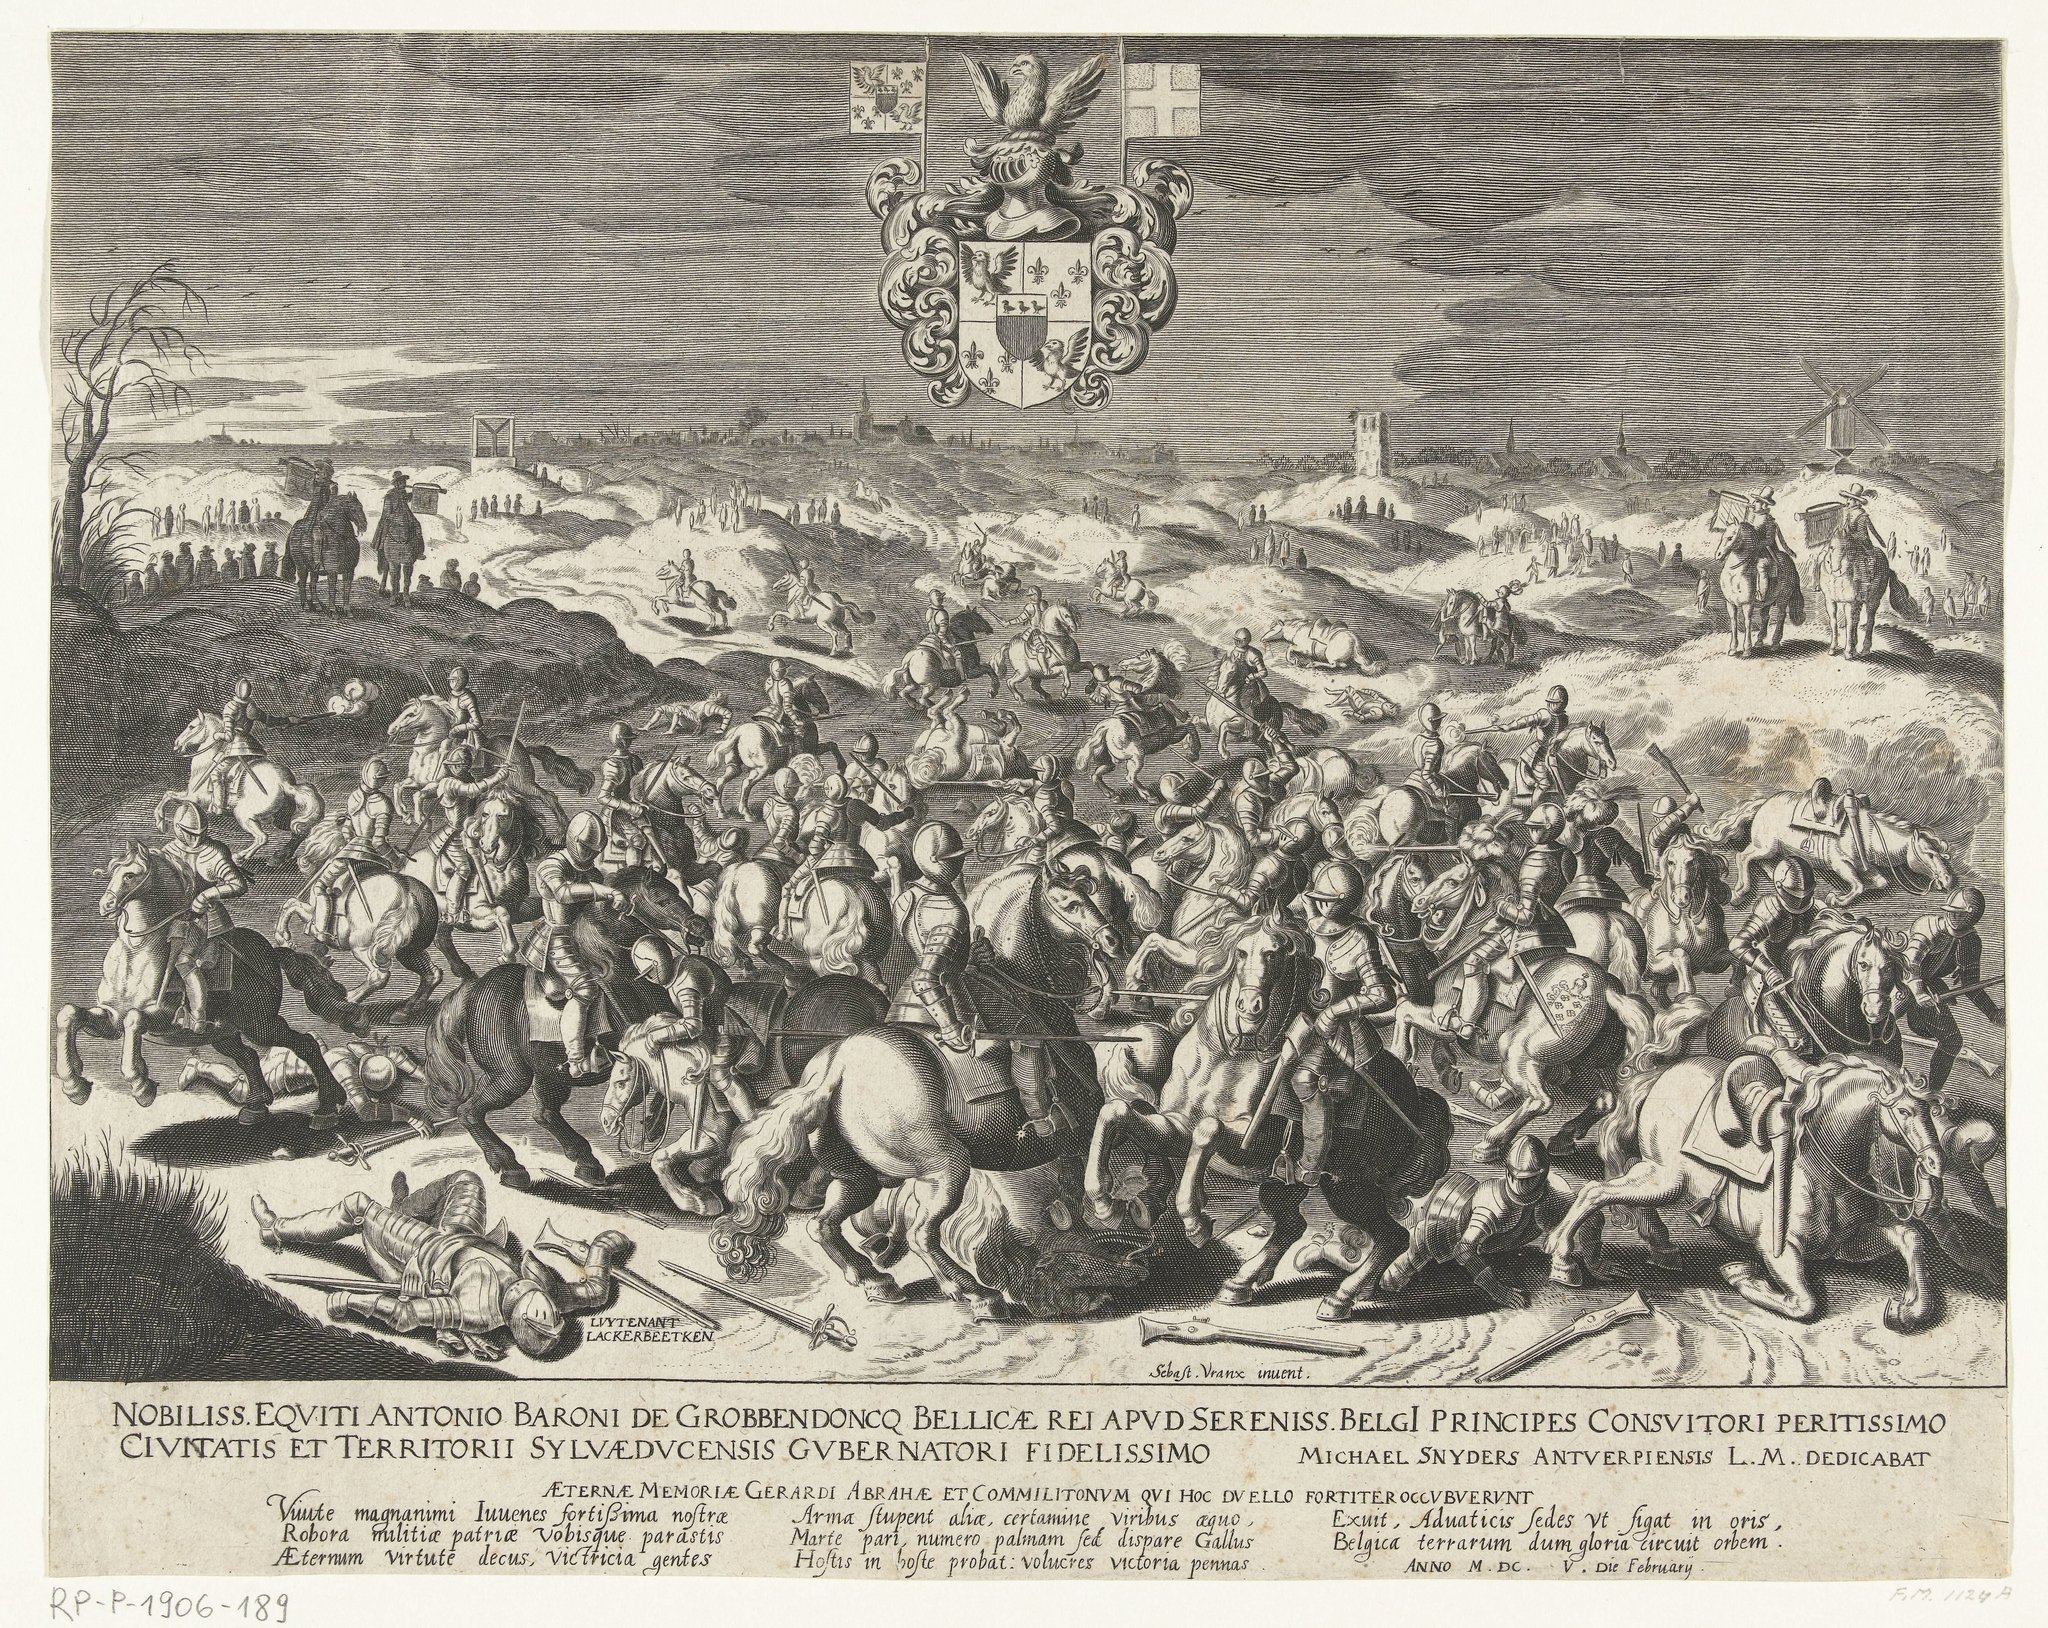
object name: print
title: Slag van Lekkerbeetje, 1600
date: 1600-1630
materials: paper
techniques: engraving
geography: southern netherlands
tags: den bosch, battle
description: Het gevecht van Lekkerbeetje. Ruitergevecht op de Vughterheide bij Den Bosch tussen de Spaanse ruiters onder Anthony Schetz van Grobbendonck en de Staatse ruiters onder de Pierre de Breauté, 5 februari 1600. Op de voorgrond links ligt de gesneuvelde Gerardt Abrahamsz. Lekkerbeetje. In de verte 's-Hertogenbosch en Vught. Bovenin het wapen van Grobbendonck. Onderaan de opdracht en een vers in 3 kolommen met opschrift in het Latijn.